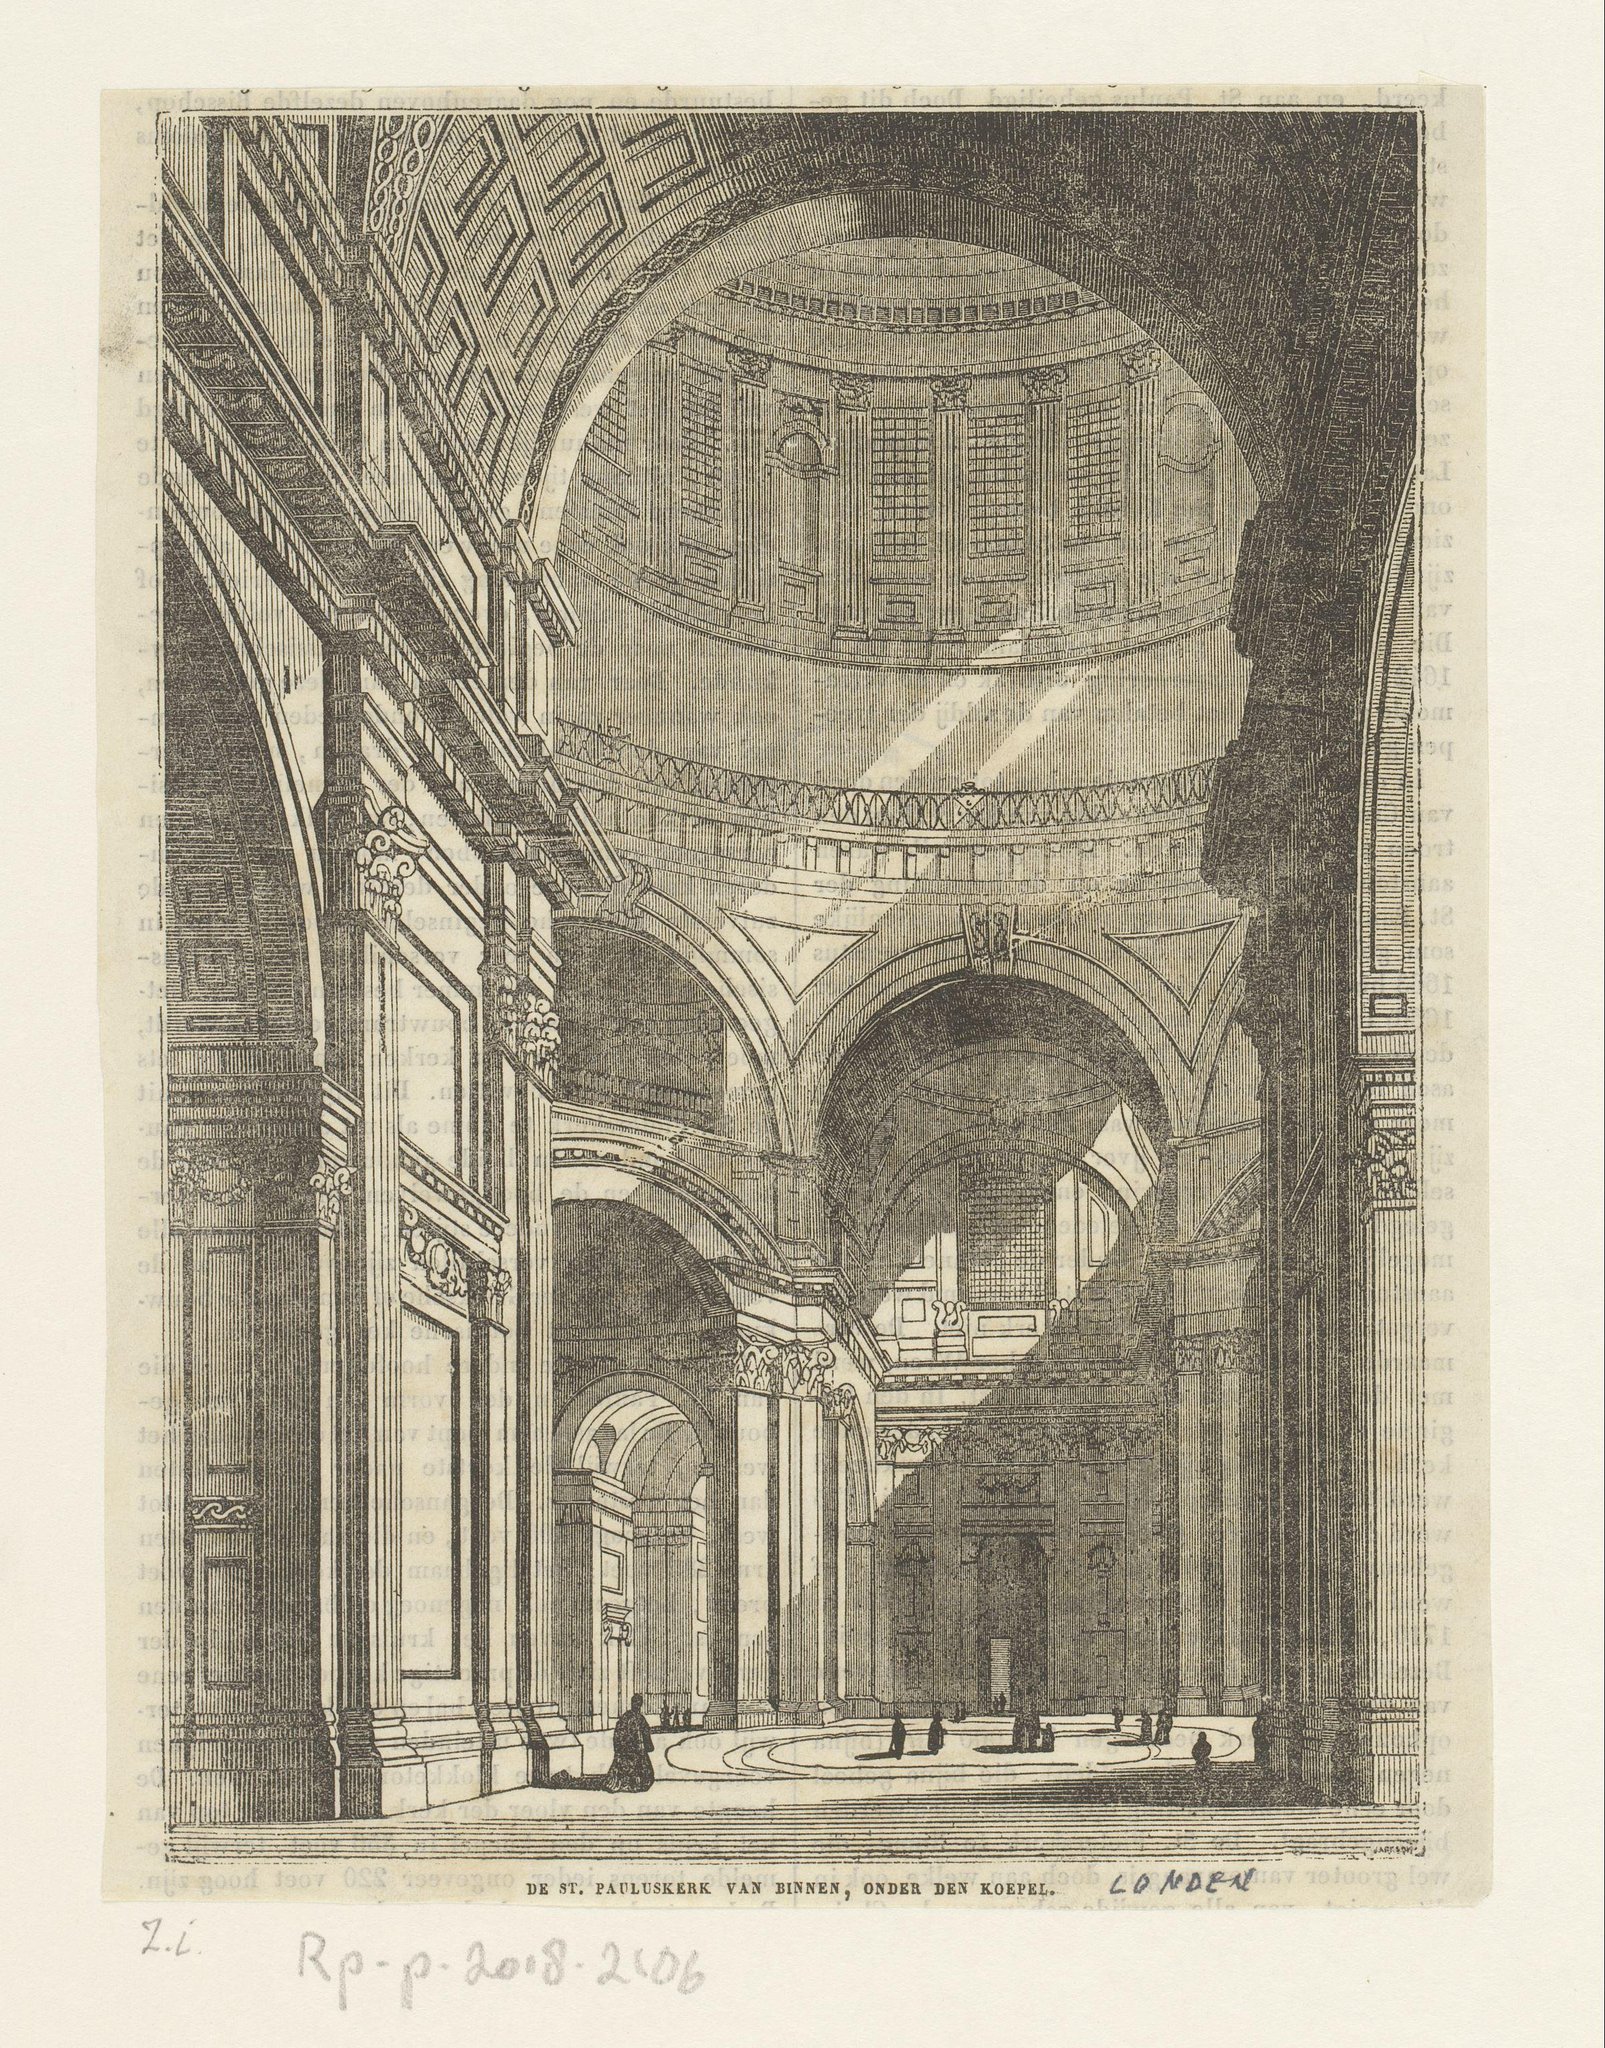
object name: print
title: De St. Pauluskerk van binnen, onder den koepel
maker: Anonymous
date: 1837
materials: paper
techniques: letterpress printing, engraving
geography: amsterdam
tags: interior of church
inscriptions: collector's mark: Lugt 2228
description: Prent gebruikt in: Nederlandsch Magazijn ter verspreiding van algemeene en nuttige kundigheden. Amsterdam: Gebroeders Diederichs, 1837.